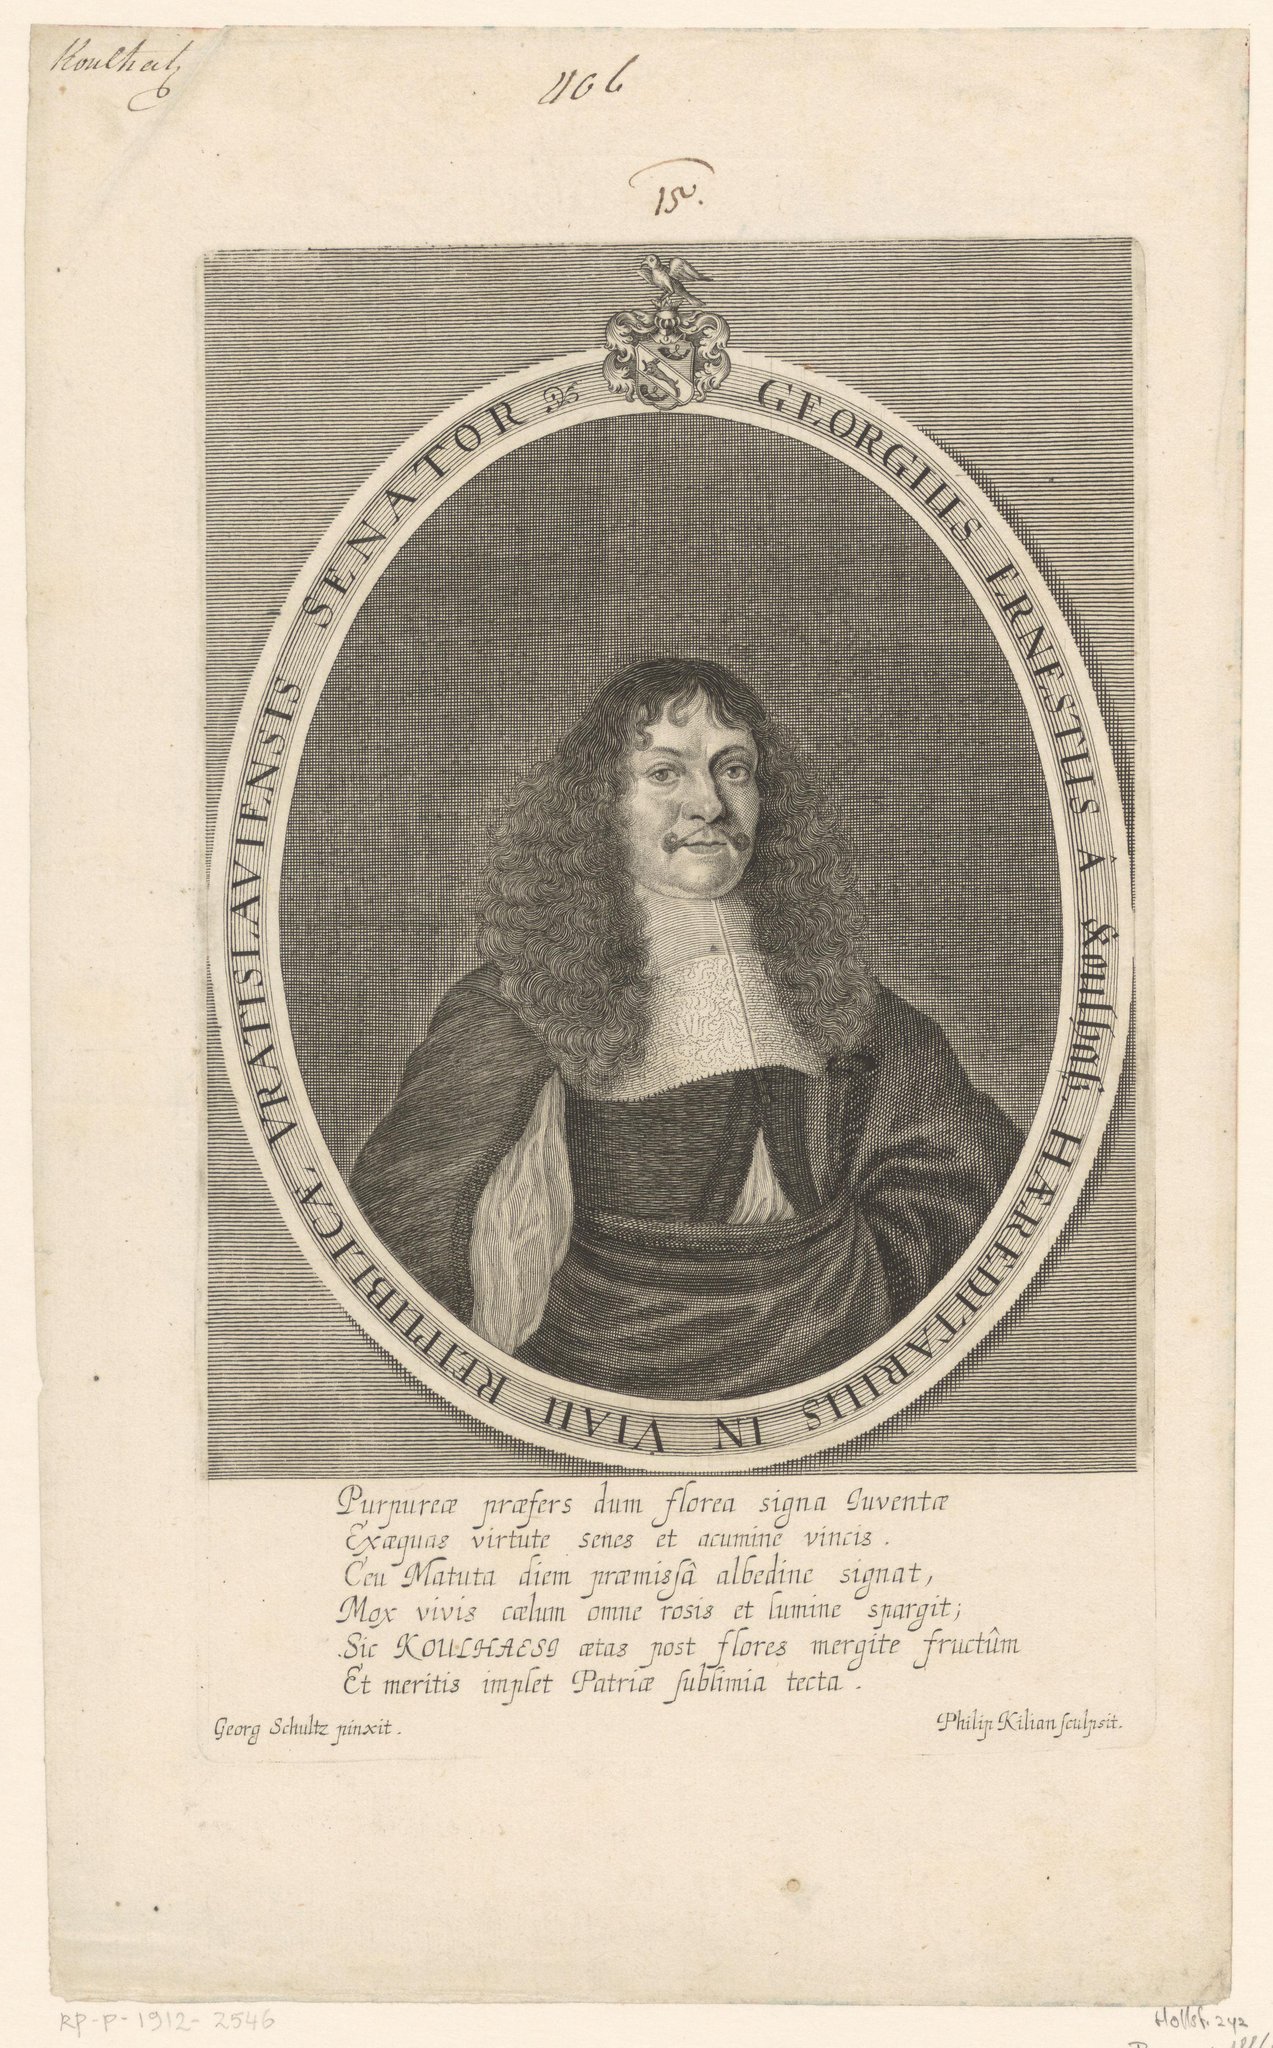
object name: print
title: Portret van Georg Ernst von Kohlhass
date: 1638-1693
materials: paper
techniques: engraving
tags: historical persons, counsellor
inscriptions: collector's mark: Lugt 2228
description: Tekst in het Latijn in de omlijsting en in de ondermarge.